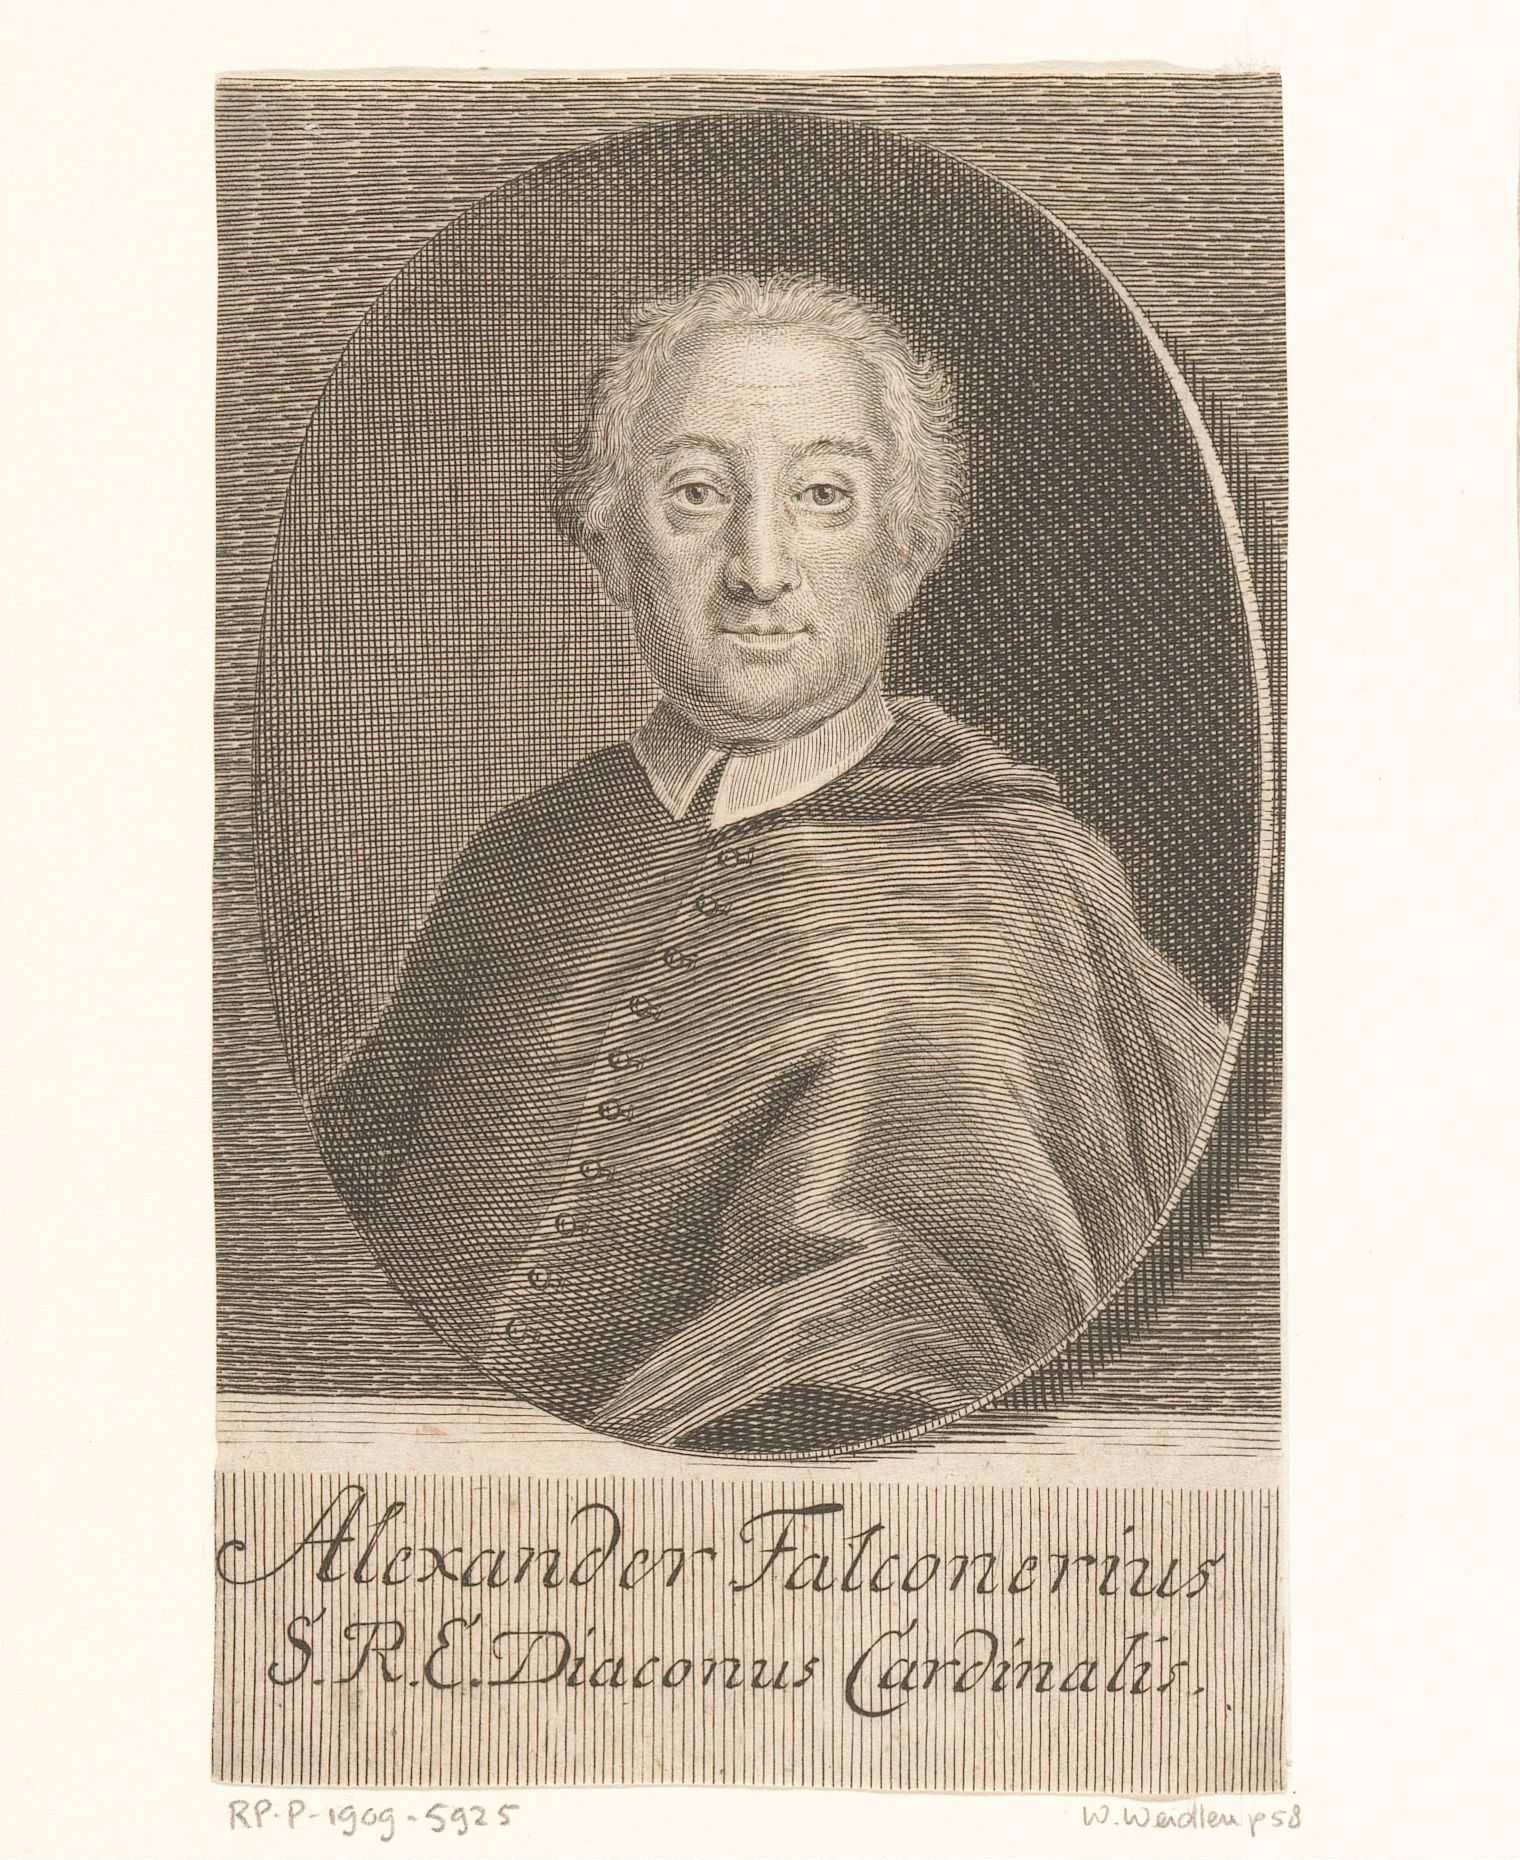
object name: print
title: Portret van Alessandro Falconieri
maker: martin bernigeroth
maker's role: print maker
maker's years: 1670-1733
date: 1725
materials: paper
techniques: engraving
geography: leipzig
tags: historical persons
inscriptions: collector's mark: Lugt 2228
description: Prent ook gebruikt in: Die Europäische Fama, Welche den gegenwärtigen Zustand der vornehmsten Höfe entdecket. dl. 281. Leipzig: Gleditsch, 1725.